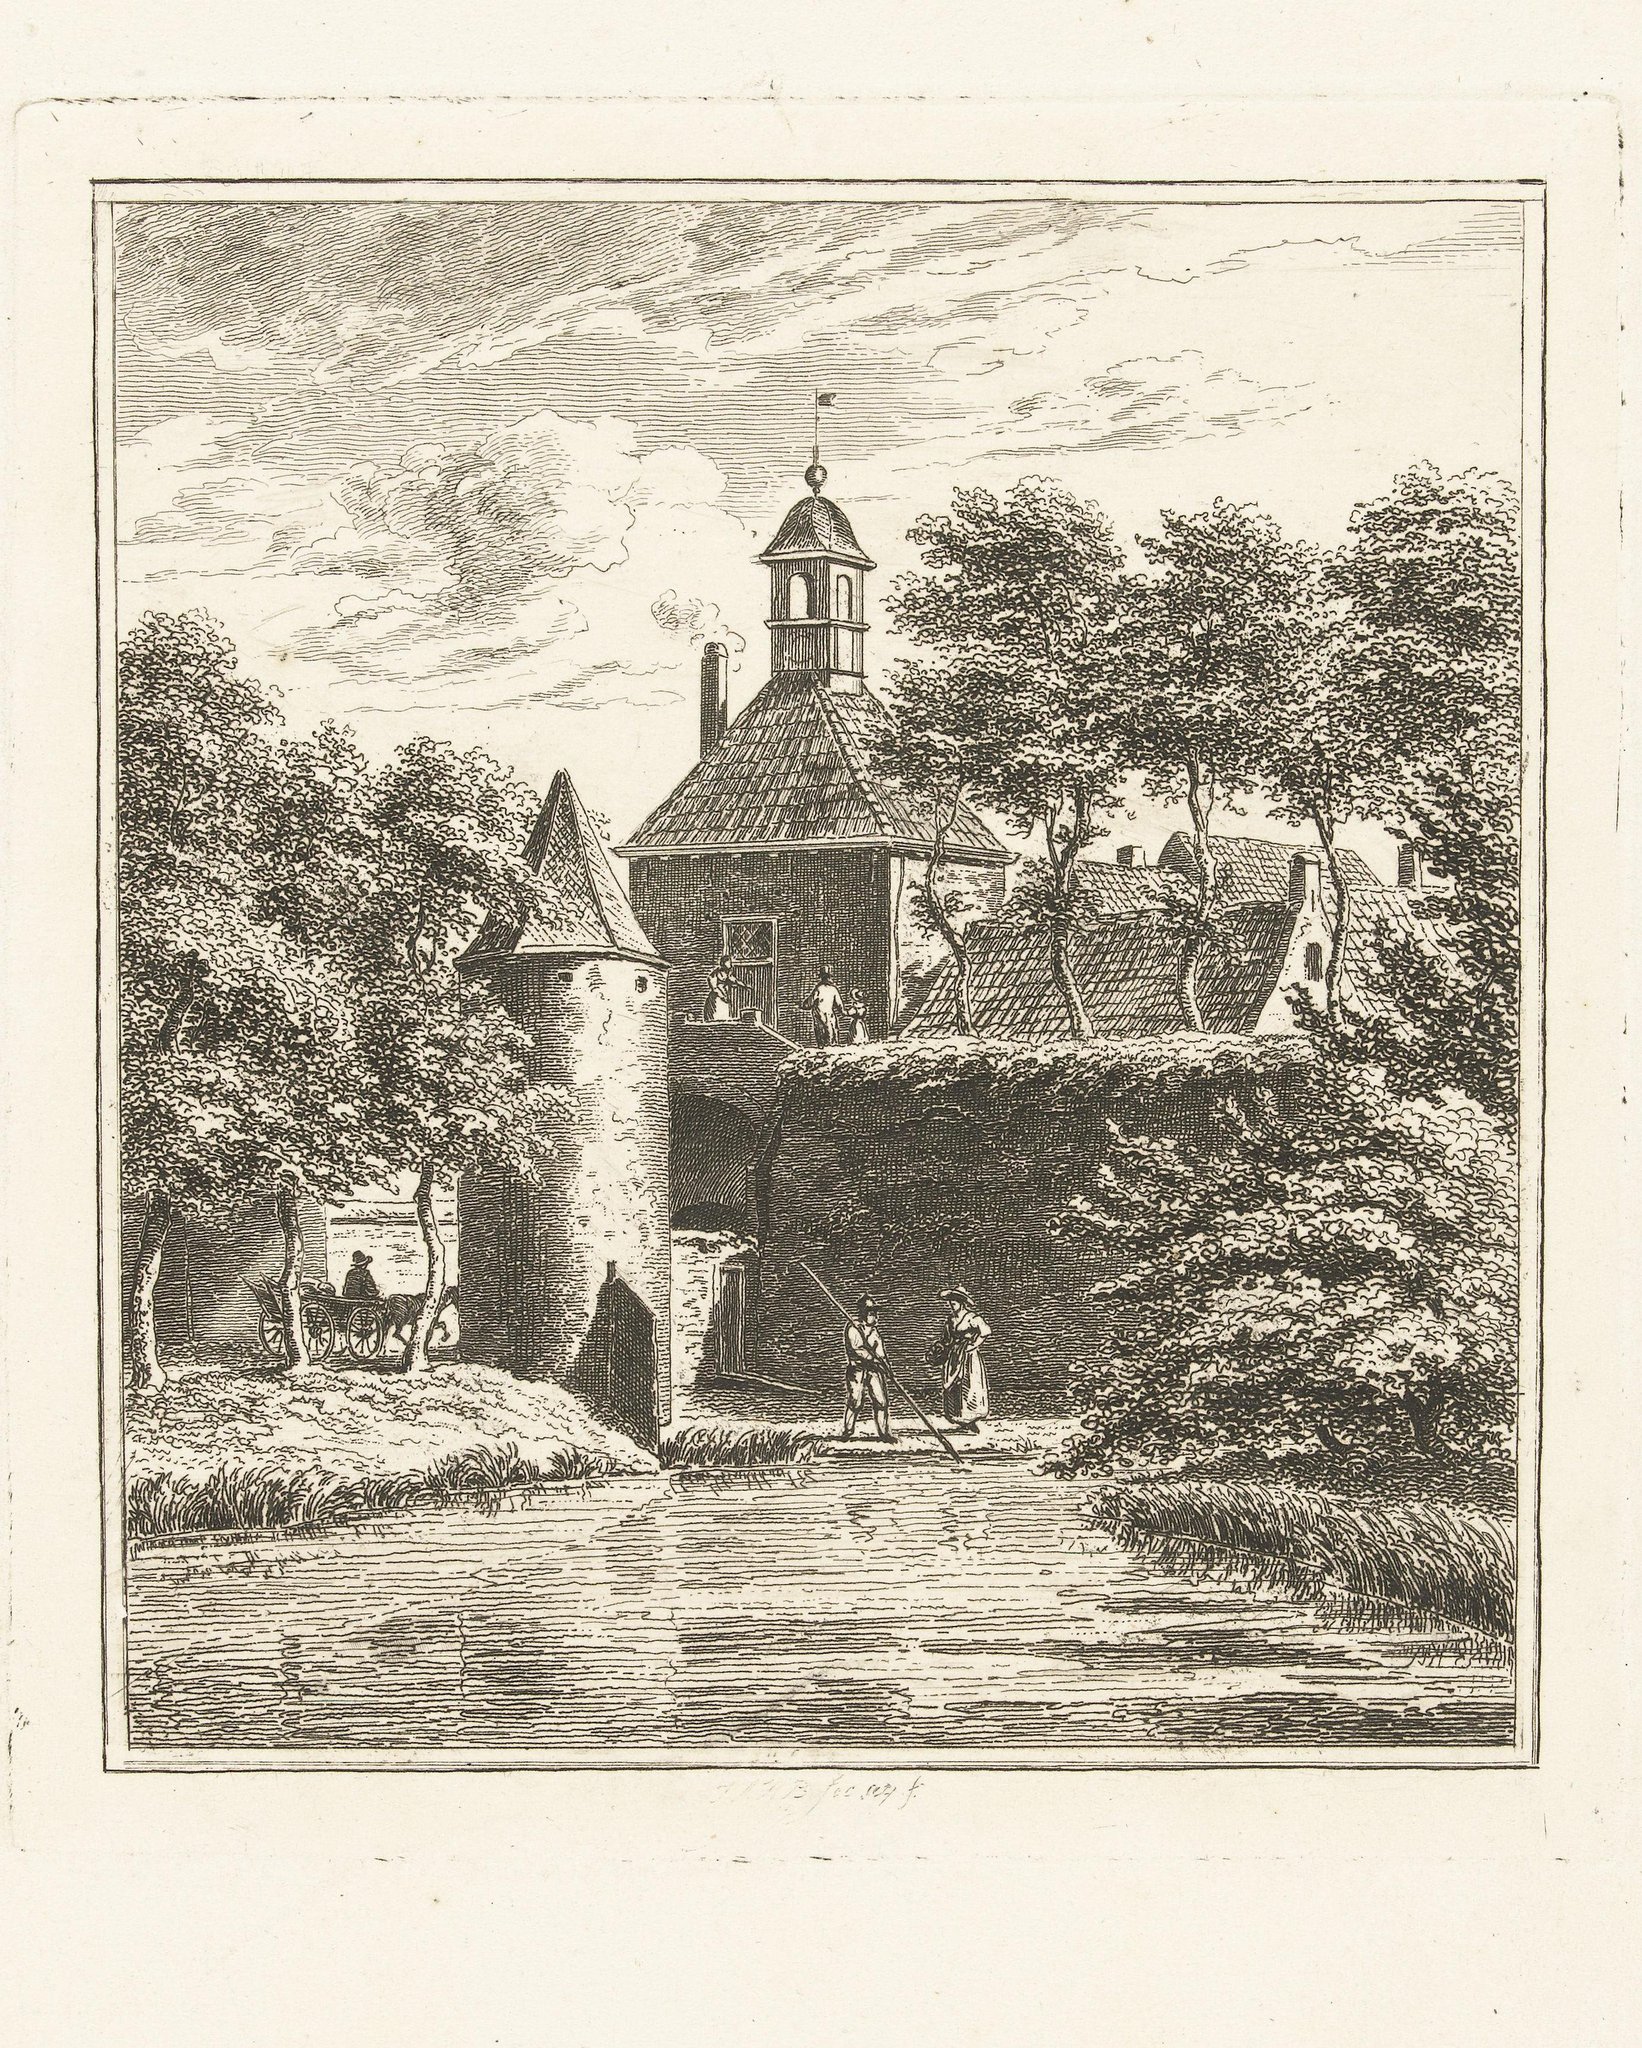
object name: print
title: Gezicht op de Burense Poort te Tiel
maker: johannes alexander rudolf best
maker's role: print maker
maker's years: 1797-1855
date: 1807-1855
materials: paper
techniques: etching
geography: amsterdam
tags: city-gate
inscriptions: inscription: ‘De Buursche poort te Tiel door J.A.R. Best zoo als dezelve was in het jaar 1828’, collector's mark: Lugt 2228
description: Mogelijk is de datering 1828 in het opschrift correct.